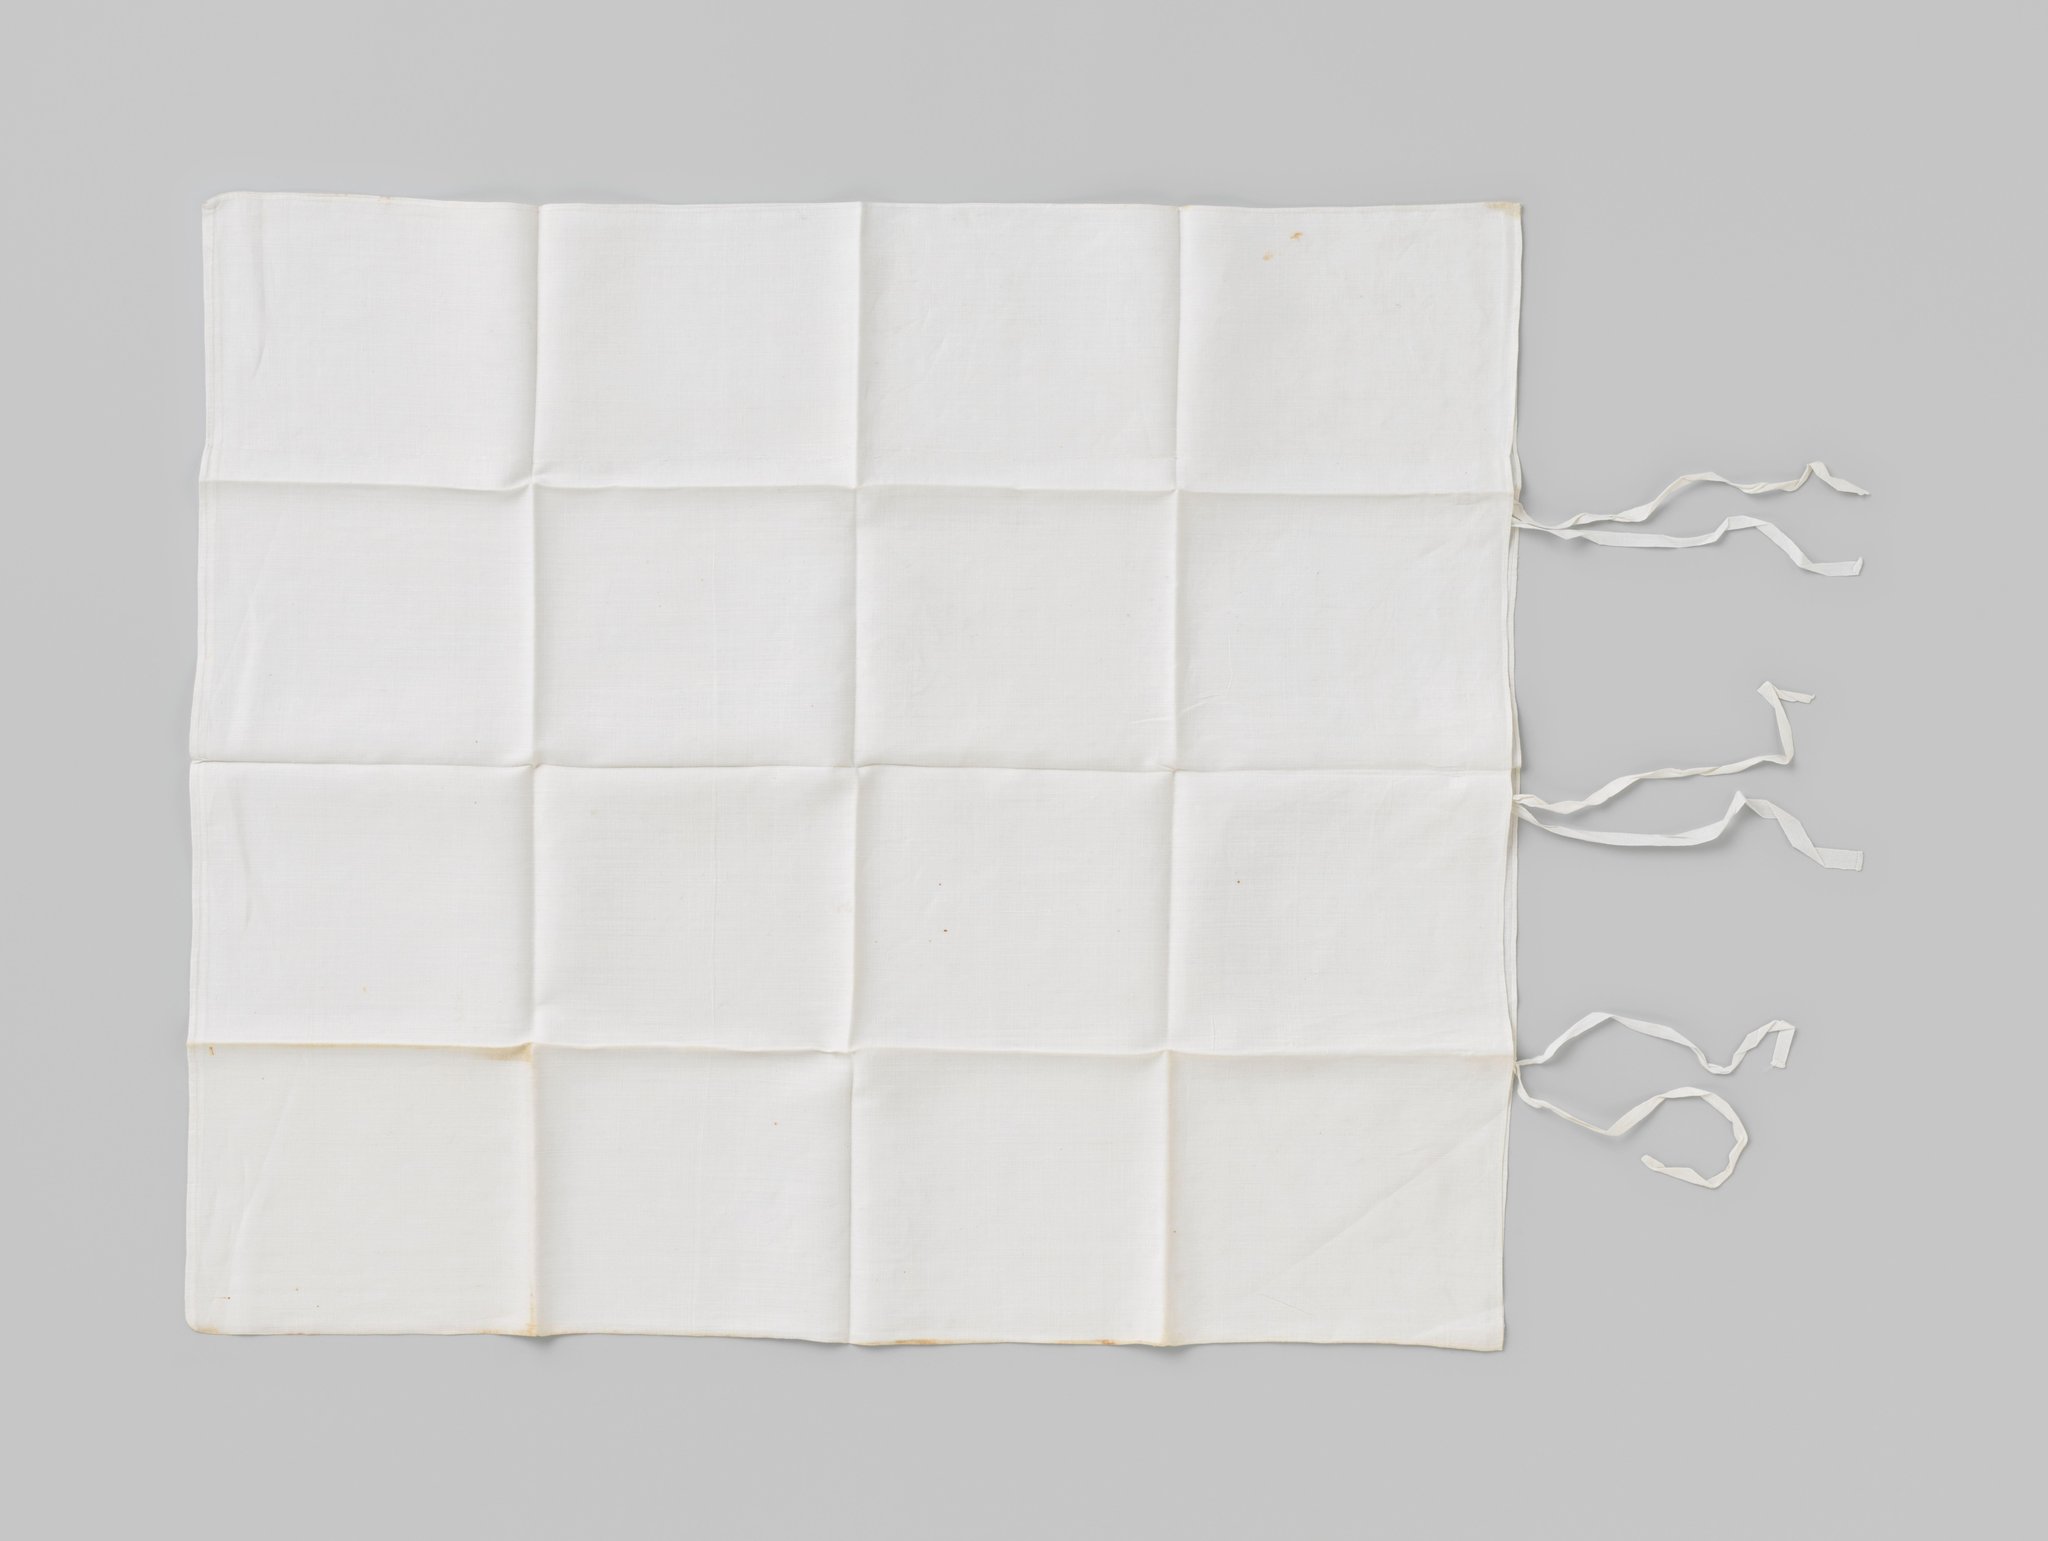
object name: pillowcase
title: Wit kussensloop van linnen, gemerkt kroon GS 24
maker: Anonymous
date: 1600-1950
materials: linen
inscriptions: mark: ‘kroon G(?)S 24’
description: Wit kussensloop van linnen. Gatenmerk kroon "GS 24" in een hoek. Koordsluiting.